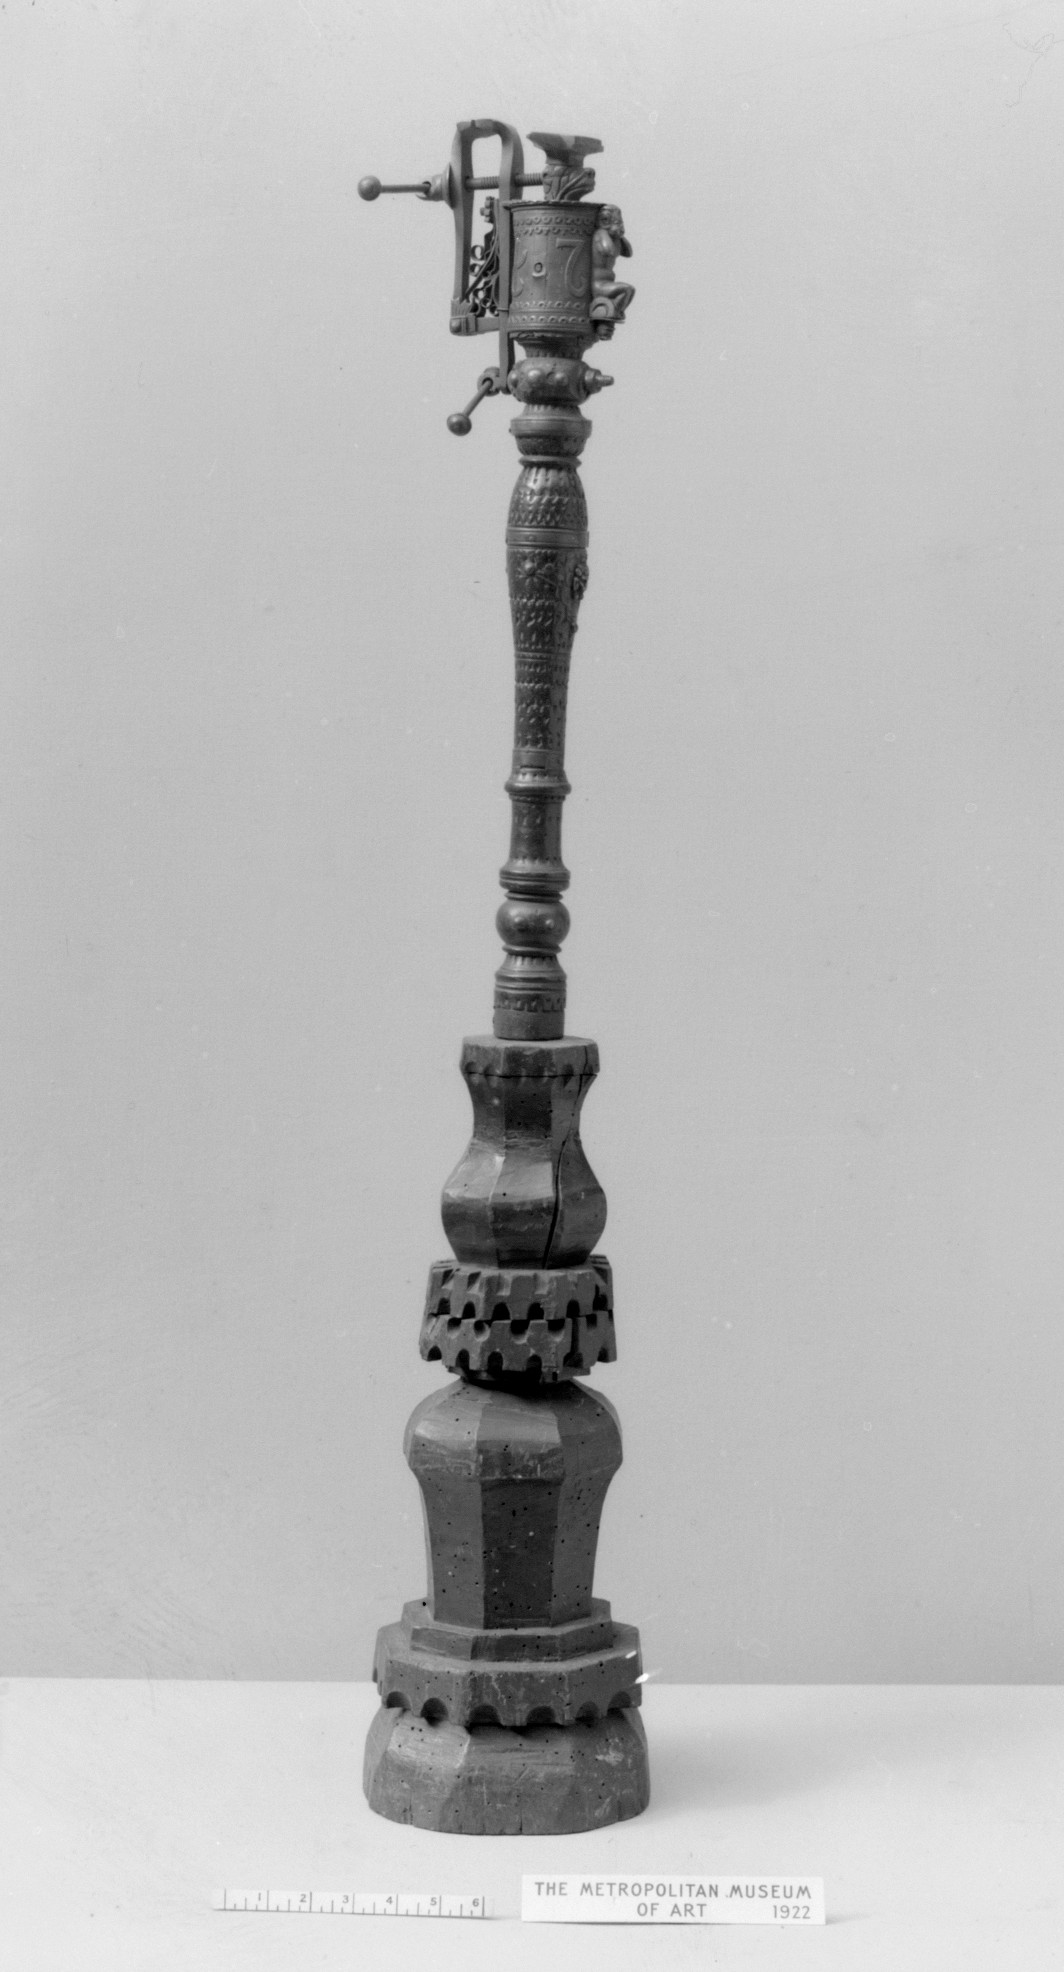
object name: anvil and vise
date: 1701-1800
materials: brass, iron